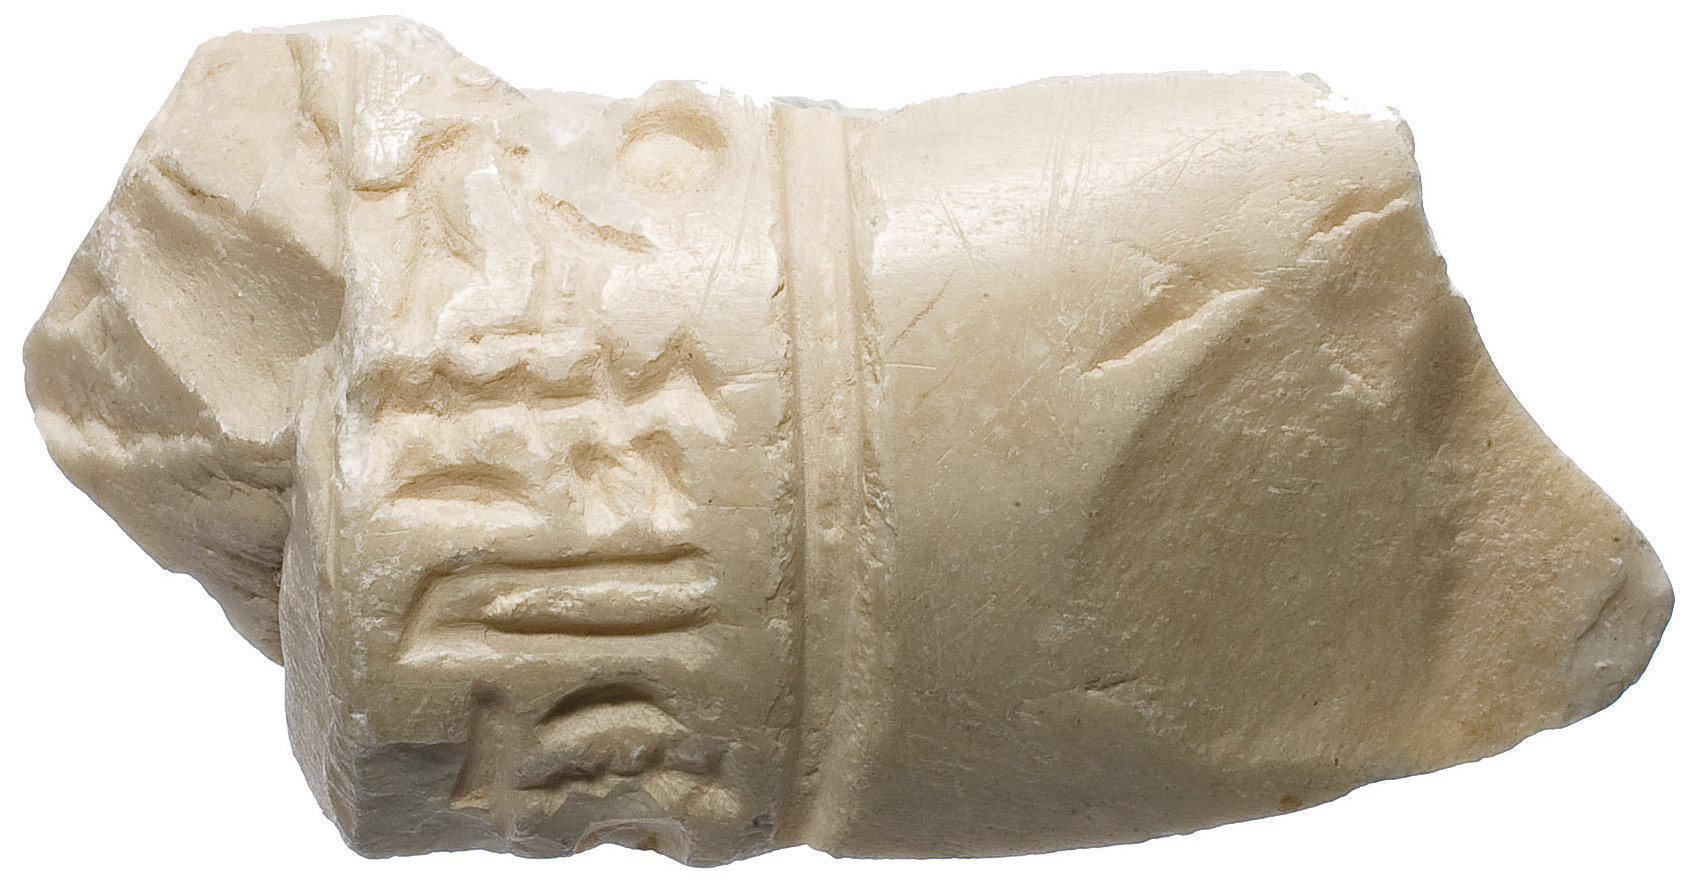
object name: arm at wrist, aten cartouch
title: Left forearm with Aten cartouche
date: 1353-1336 BCE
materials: limestone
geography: egypt